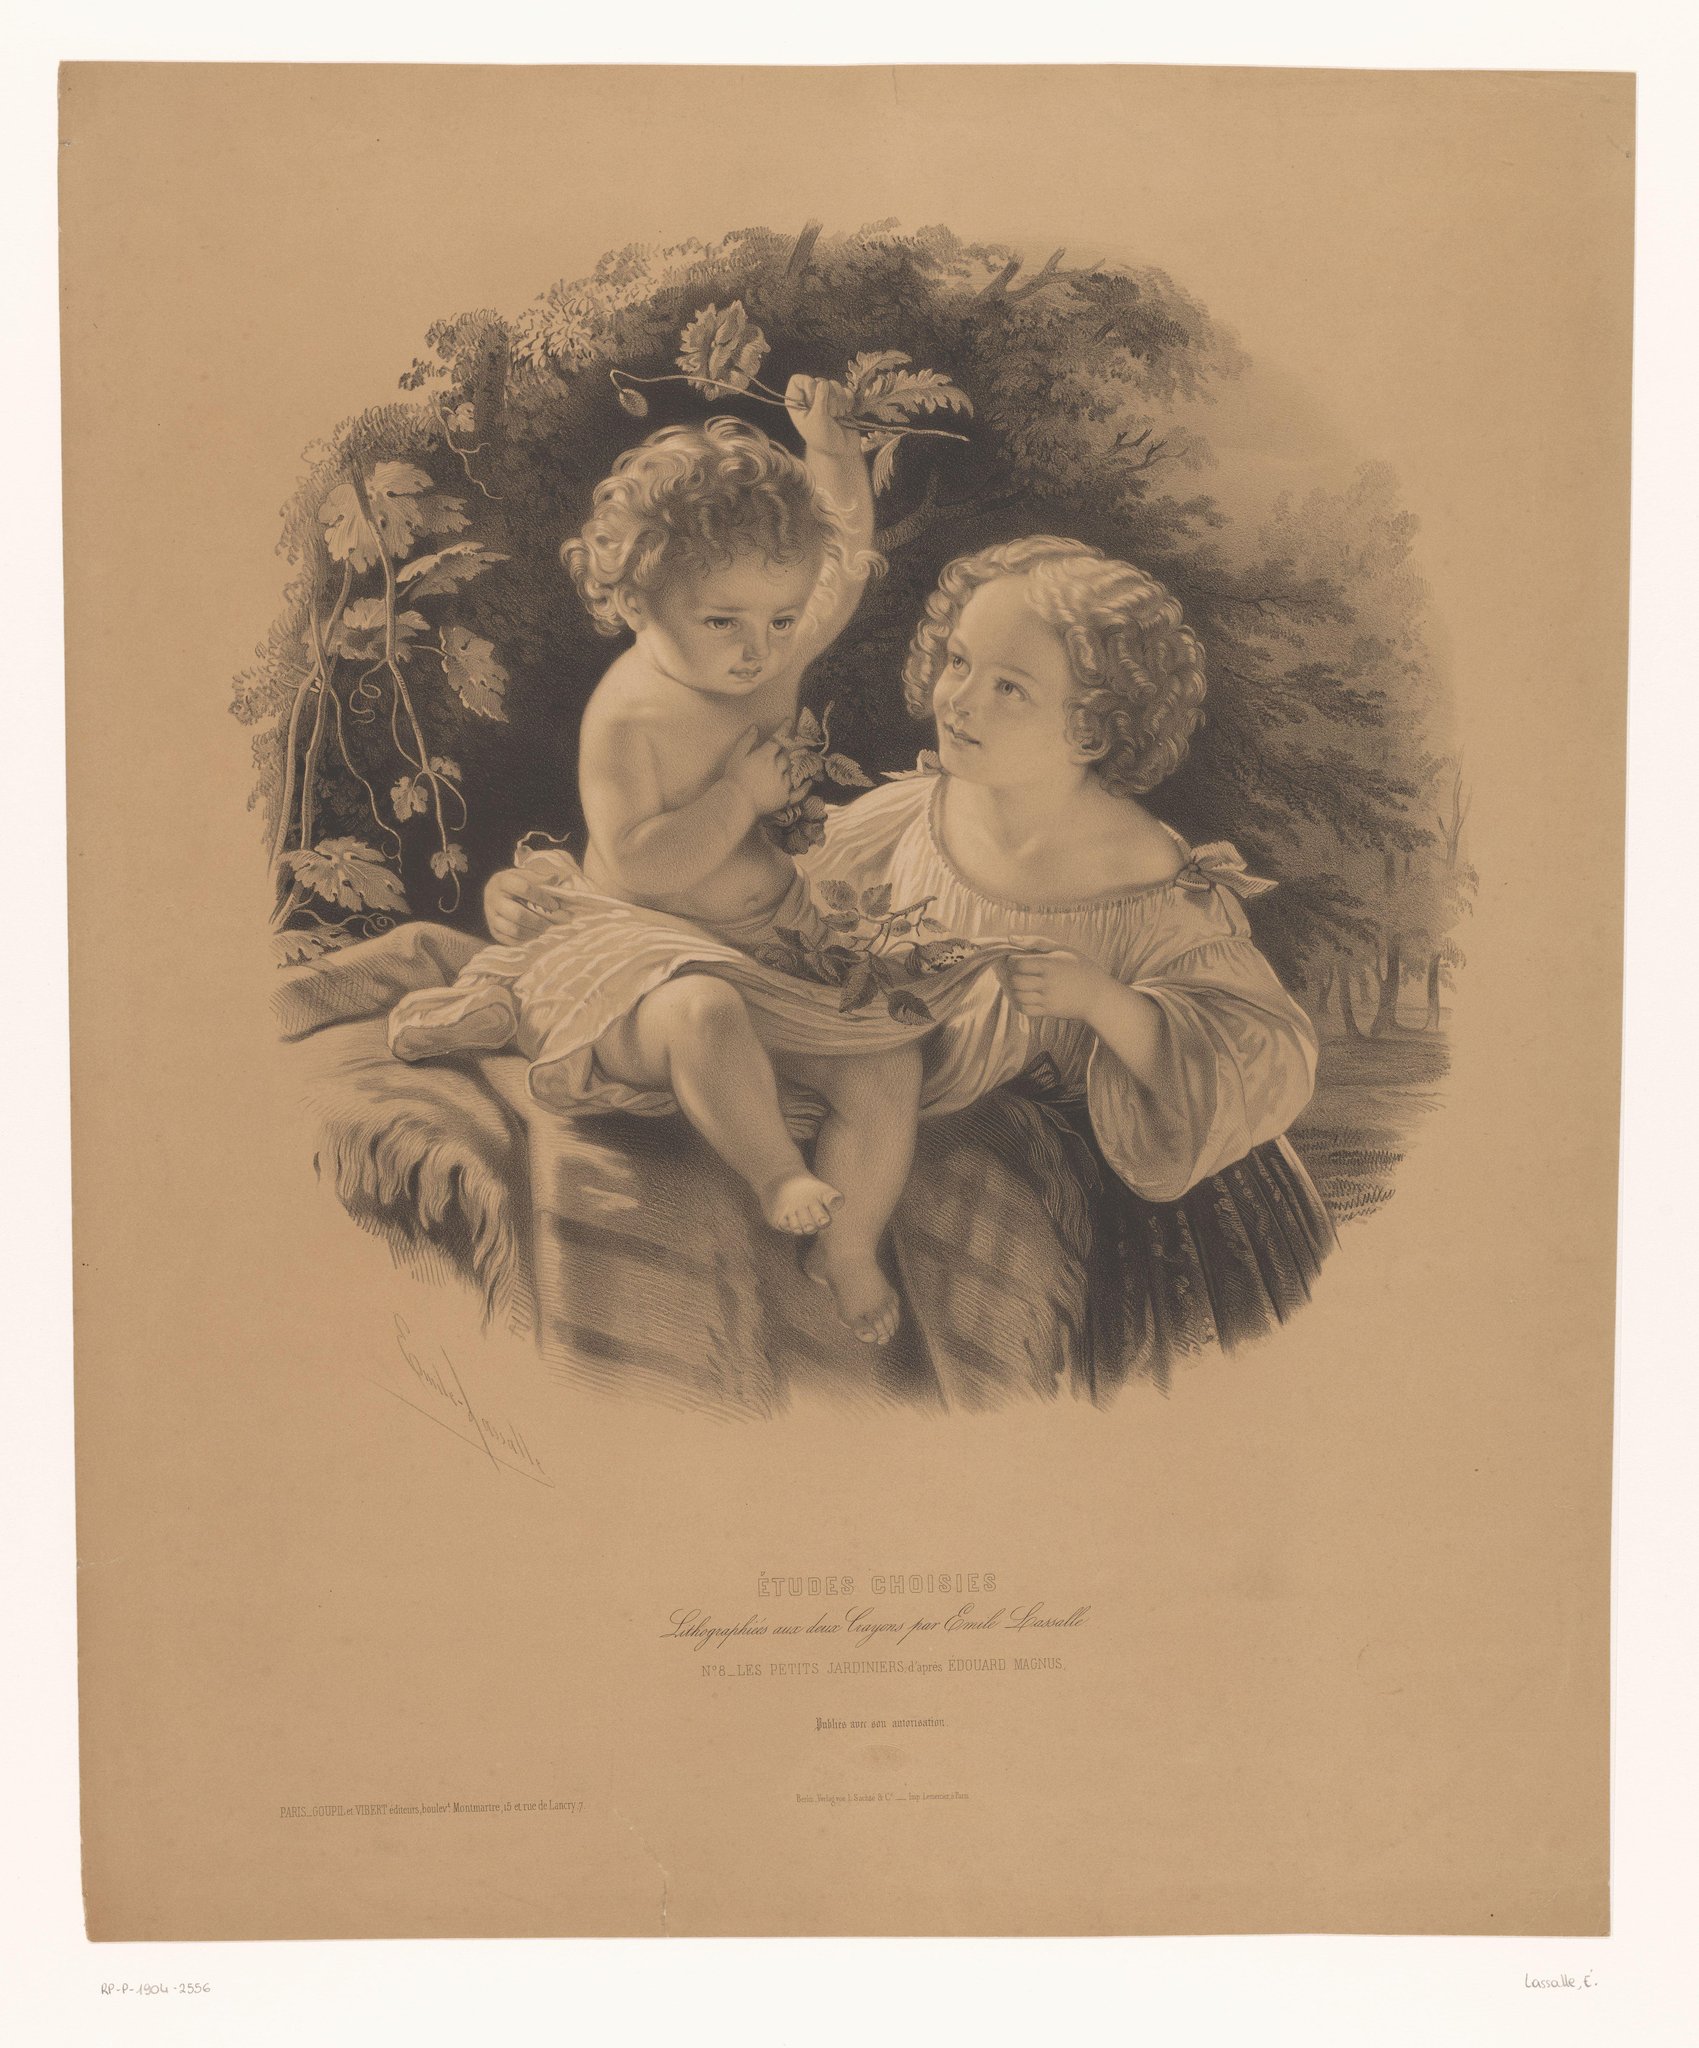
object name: print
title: Studies van geselecteerde kunstenaars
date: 1844-1850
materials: paper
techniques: tone lithography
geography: paris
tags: playing toddler; child amusing itself, girl (child between toddler and youth), forest, wood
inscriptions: collector's mark: Lugt 2228, check stamp: Lugt 5003